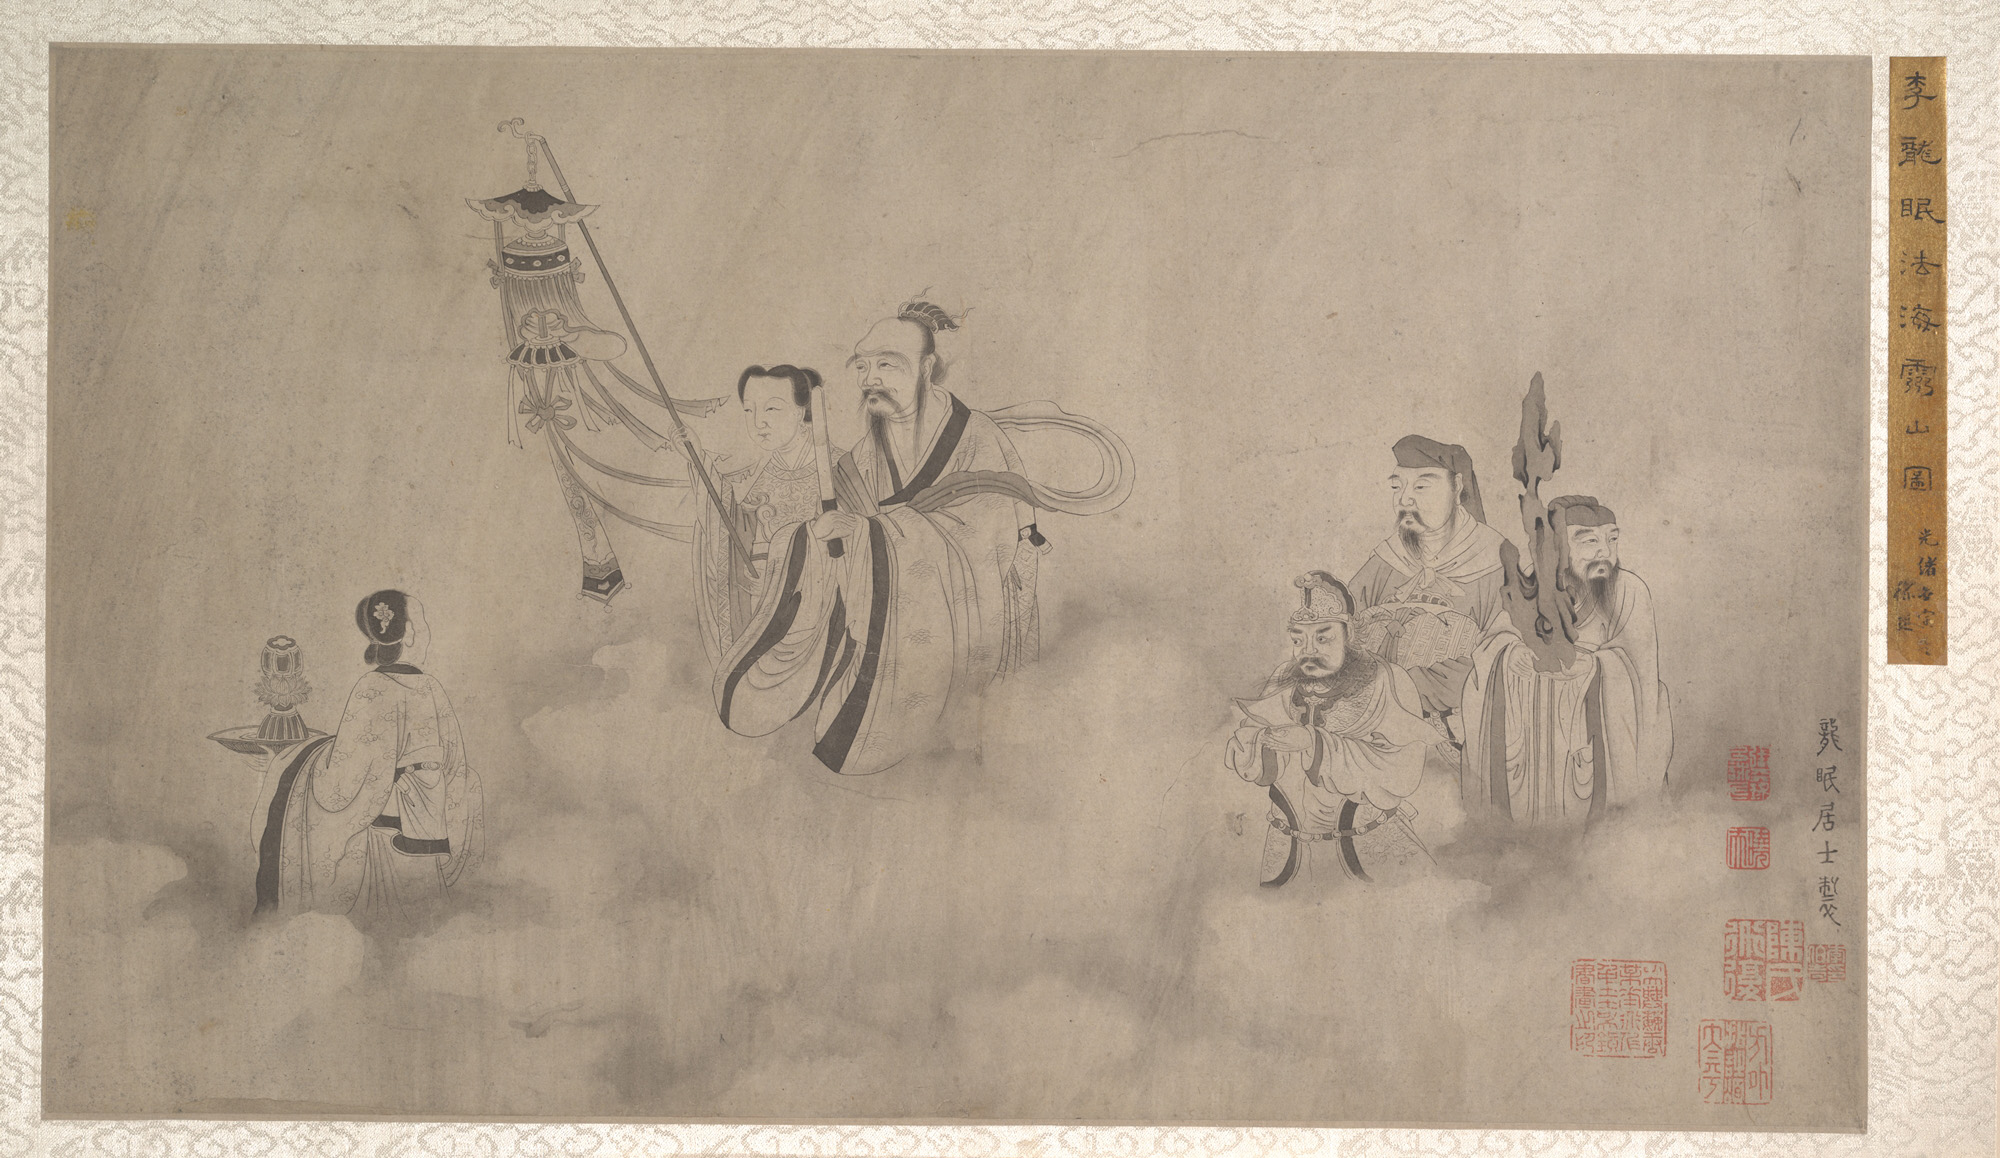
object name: album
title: Procession of Arhats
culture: chinese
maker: unidentified artist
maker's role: artist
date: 1368-1911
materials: ink, silk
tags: men,women,lanterns